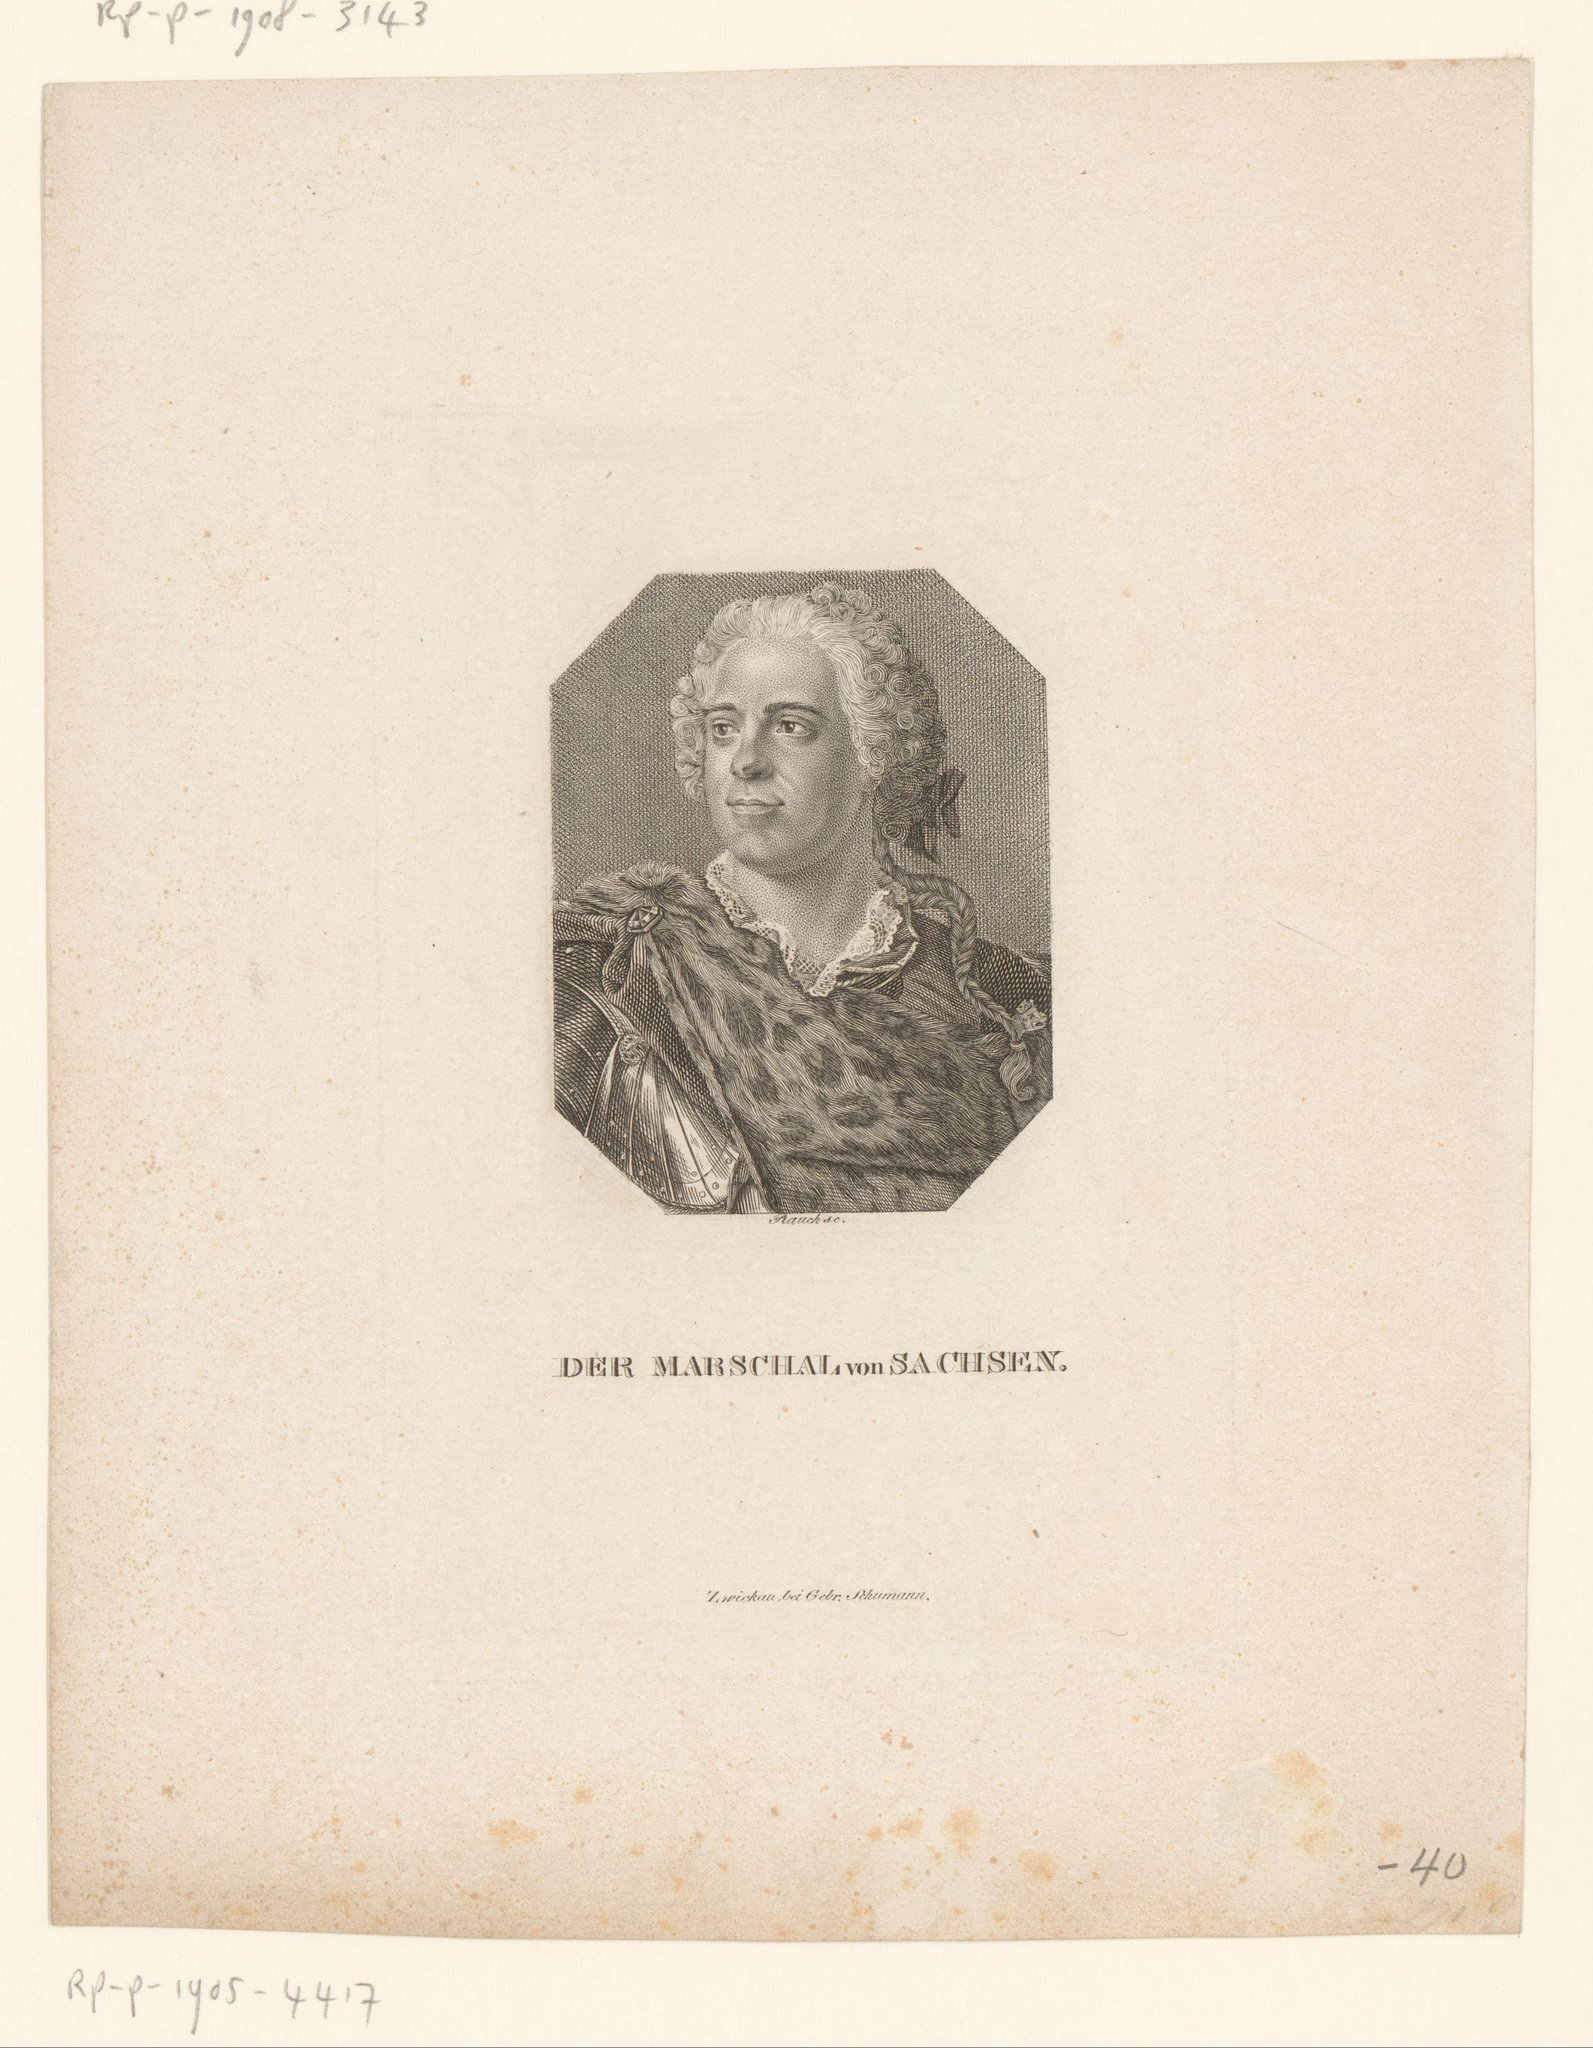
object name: print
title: Portret van Moritz, Graf von Sachsen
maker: ernst rauch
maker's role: print maker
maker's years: 1797-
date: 1807-1899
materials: paper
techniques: engraving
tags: moritz graf von sachsen, armour, historical persons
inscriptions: collector's mark: Lugt 2228